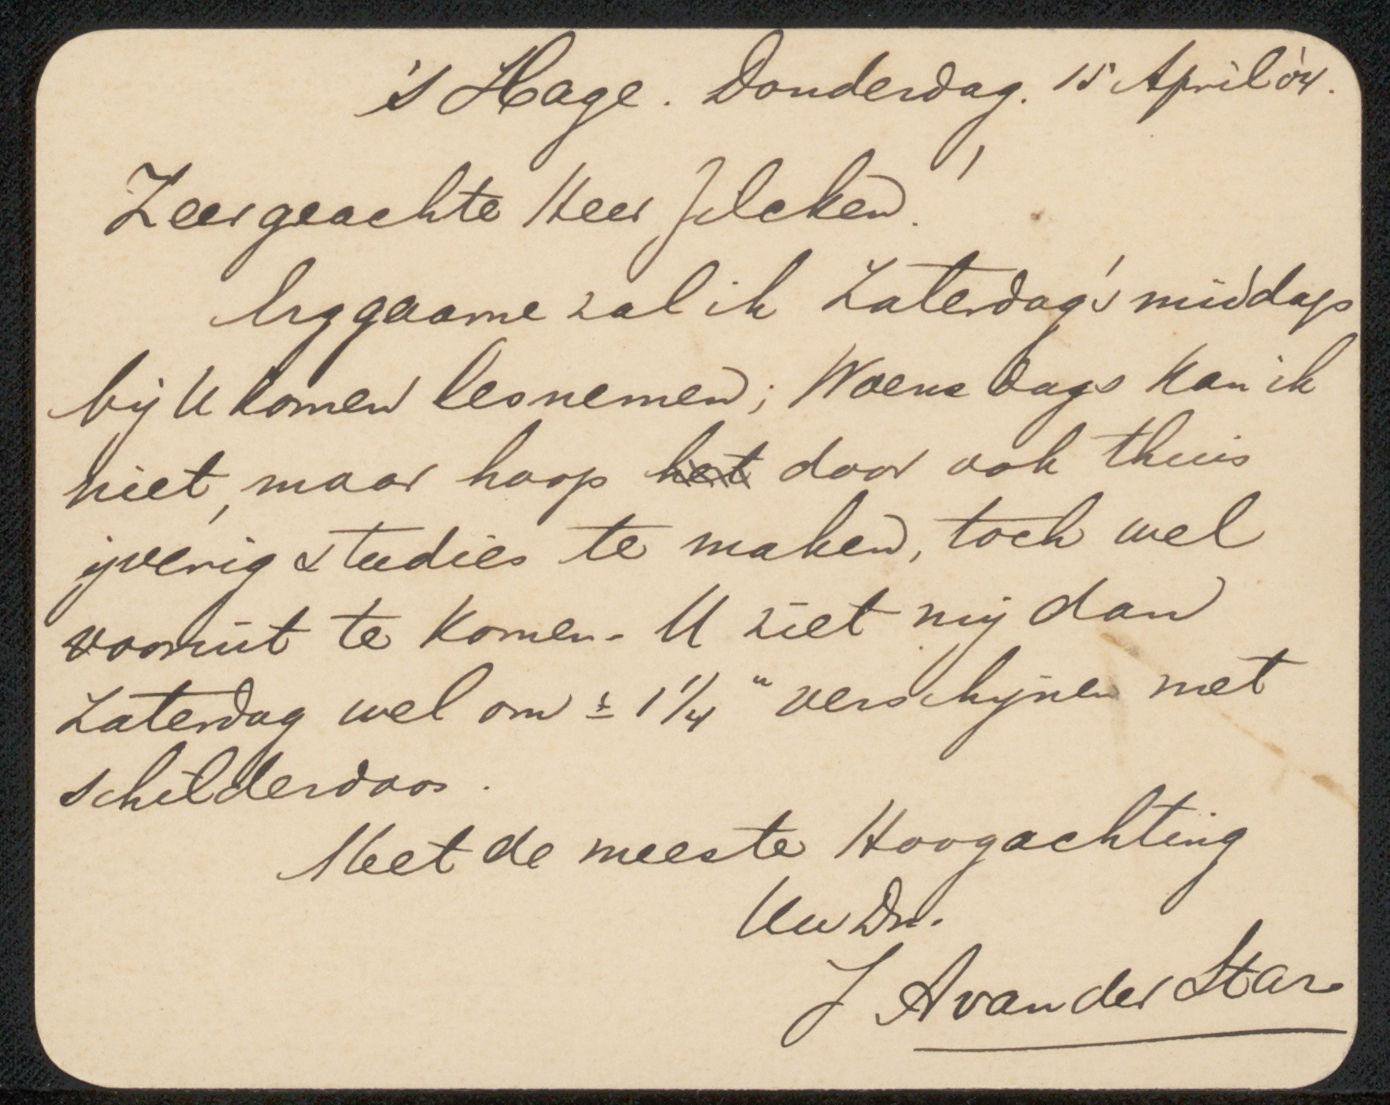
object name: letter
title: Brief aan Philip Zilcken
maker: j.a. van der star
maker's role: schrijver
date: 1904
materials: cardboard, ink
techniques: pen, writing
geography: the hague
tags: painter, draughtsman, philip zilcken, education, tuition of the artist (in general), painting (including book-illumination, miniature-painting)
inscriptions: collector's mark: ‘RPK’